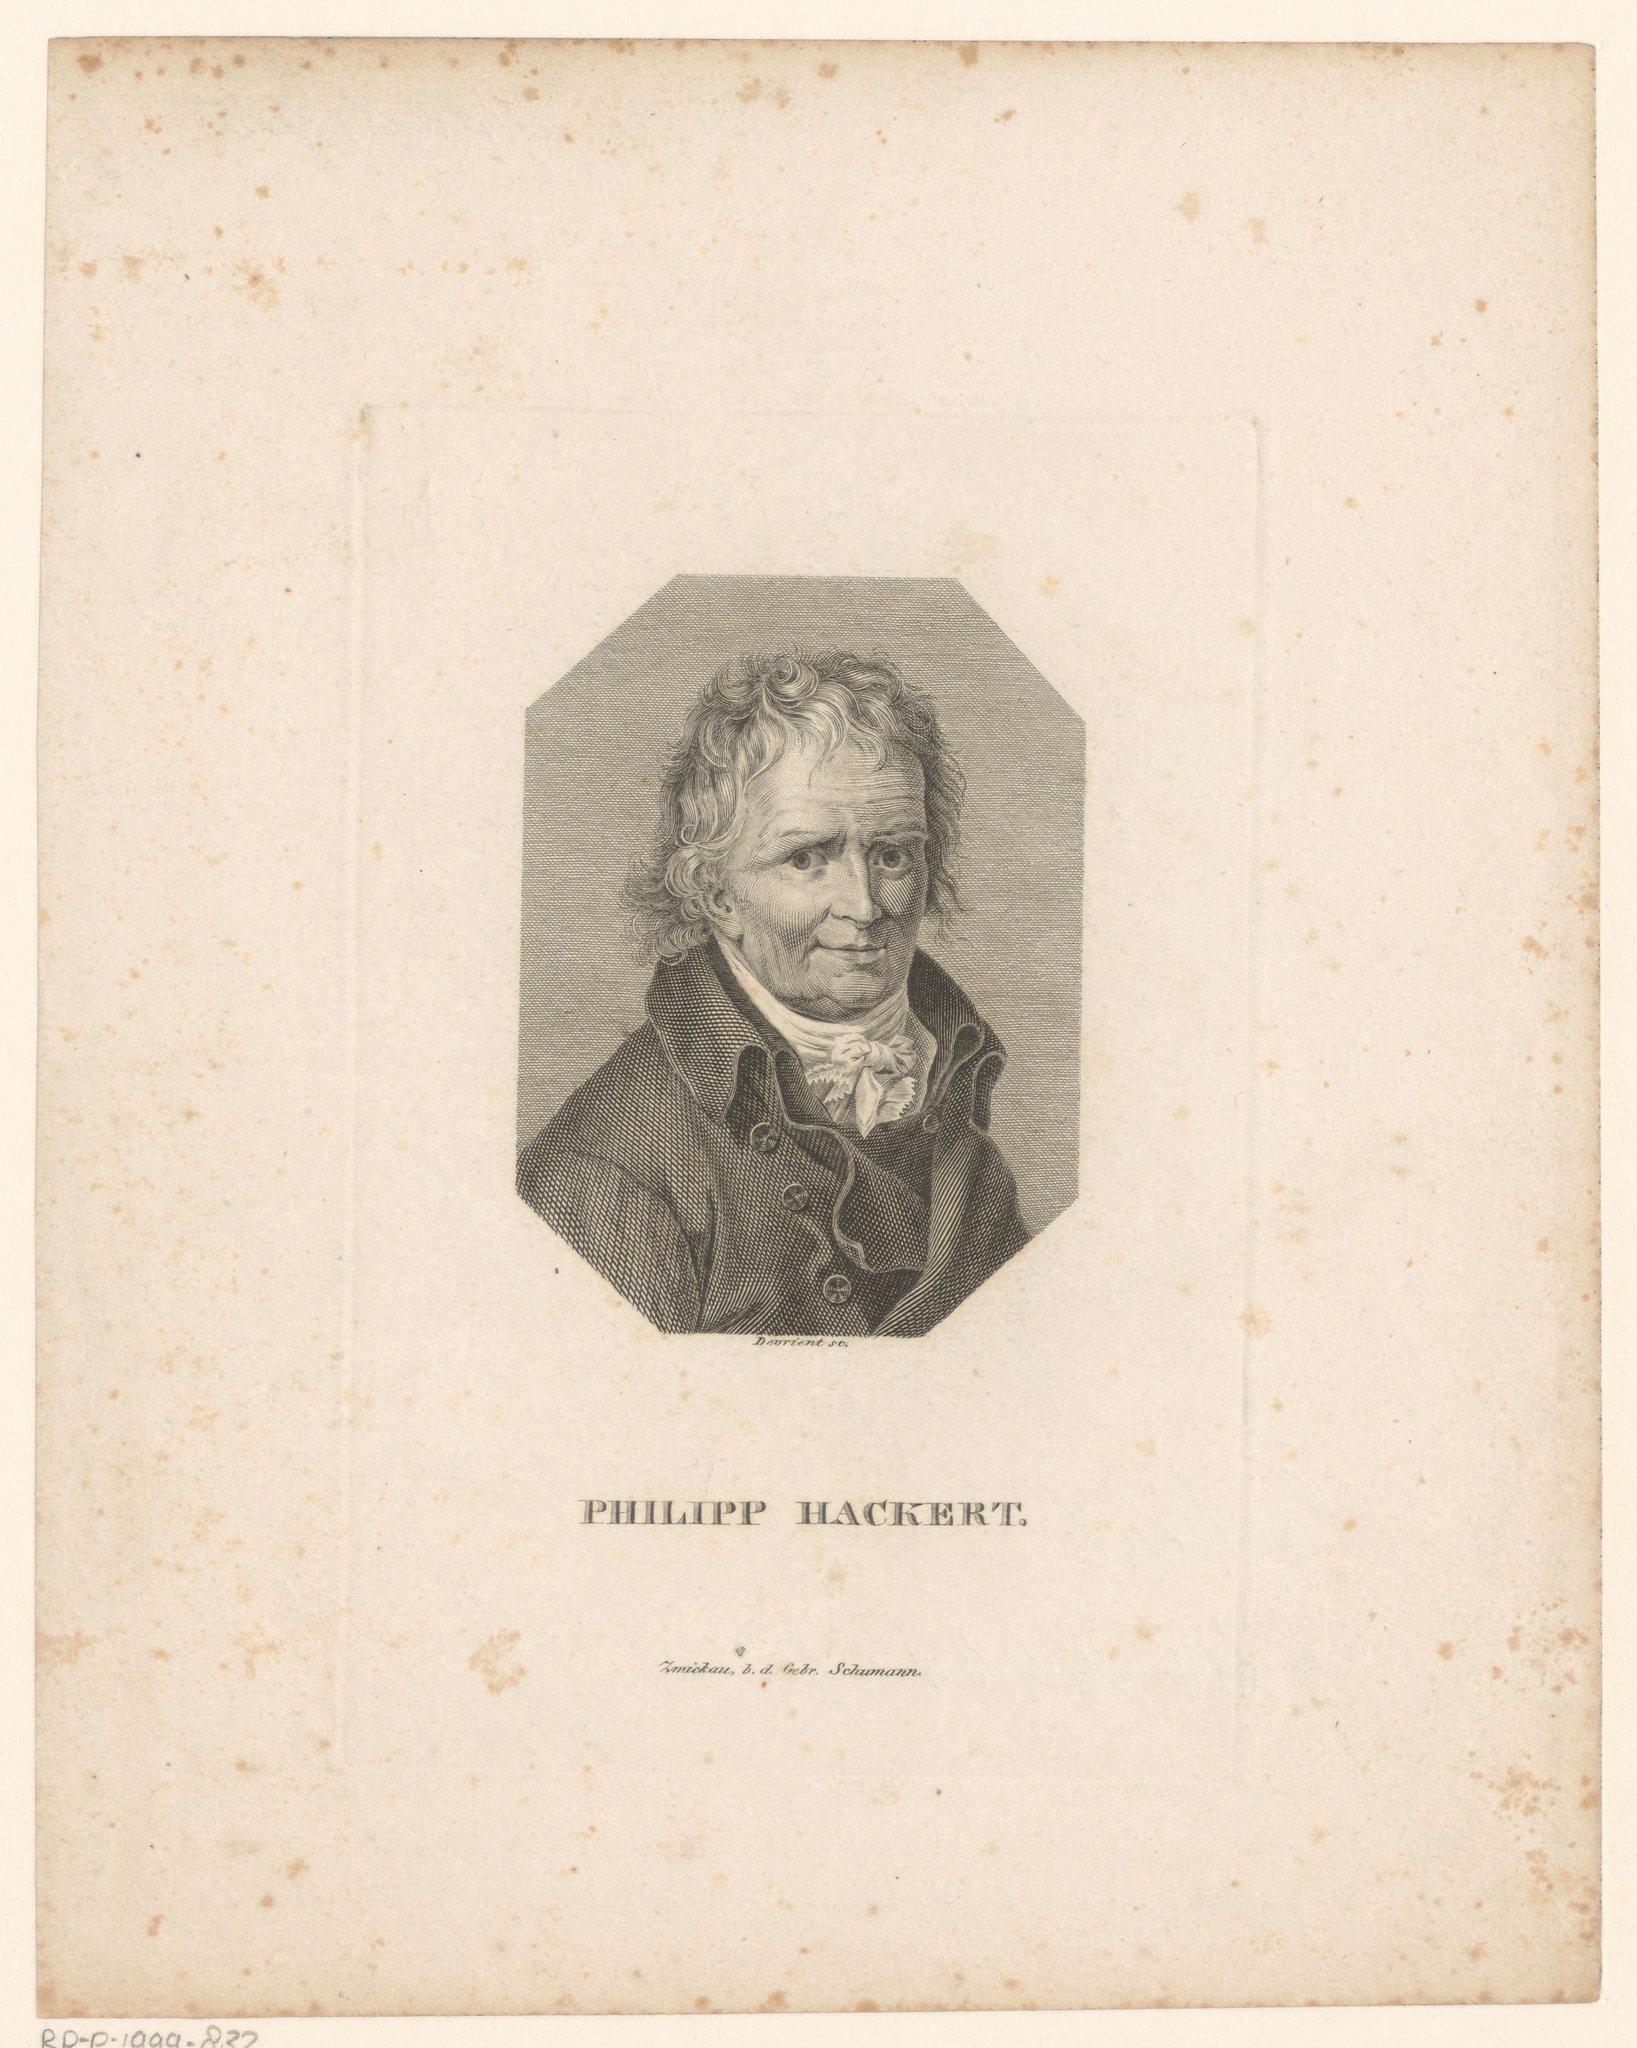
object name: print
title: Bildnisse der berühmtesten Menschen aller Völker und Zeiten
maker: wilhelm devrient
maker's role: print maker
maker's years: 1799-1866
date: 1818-1832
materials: paper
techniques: engraving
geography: germany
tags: historical persons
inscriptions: collector's mark: Lugt 2760, collector's mark: Lugt 2228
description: Prent afkomstig uit: 'Bildnisse der berühmtesten Menschen aller Völker und Zeiten' van de gebroeders Schumann, uitgegeven in 1818-1832 te Zwickau.